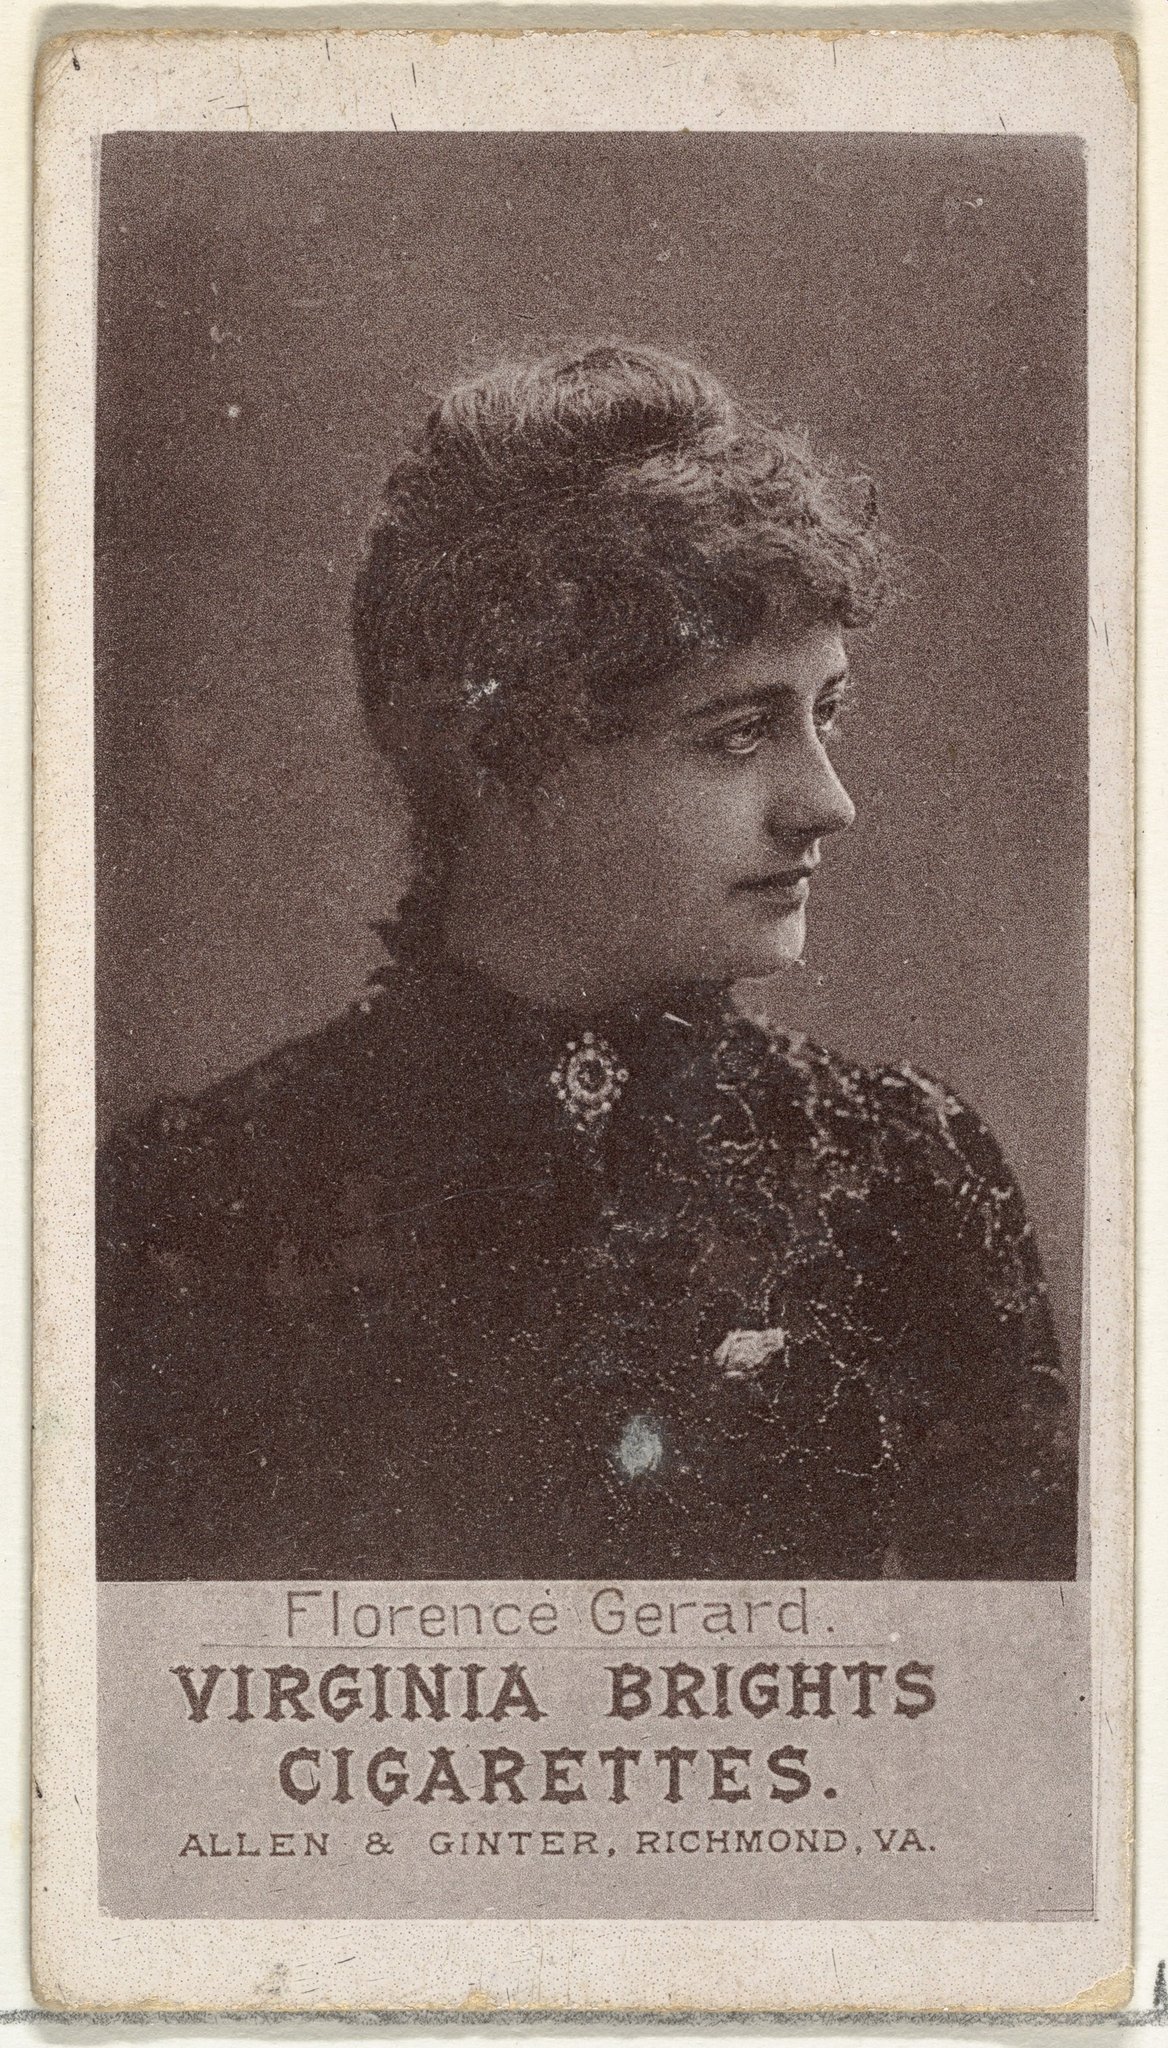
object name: print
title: Florence Gerard, from the Actresses series (N67) promoting Virginia Brights Cigarettes for Allen & Ginter brand tobacco products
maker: allen & ginter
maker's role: publisher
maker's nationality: american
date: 1888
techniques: photolithograph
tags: portraits,profiles,women,actresses